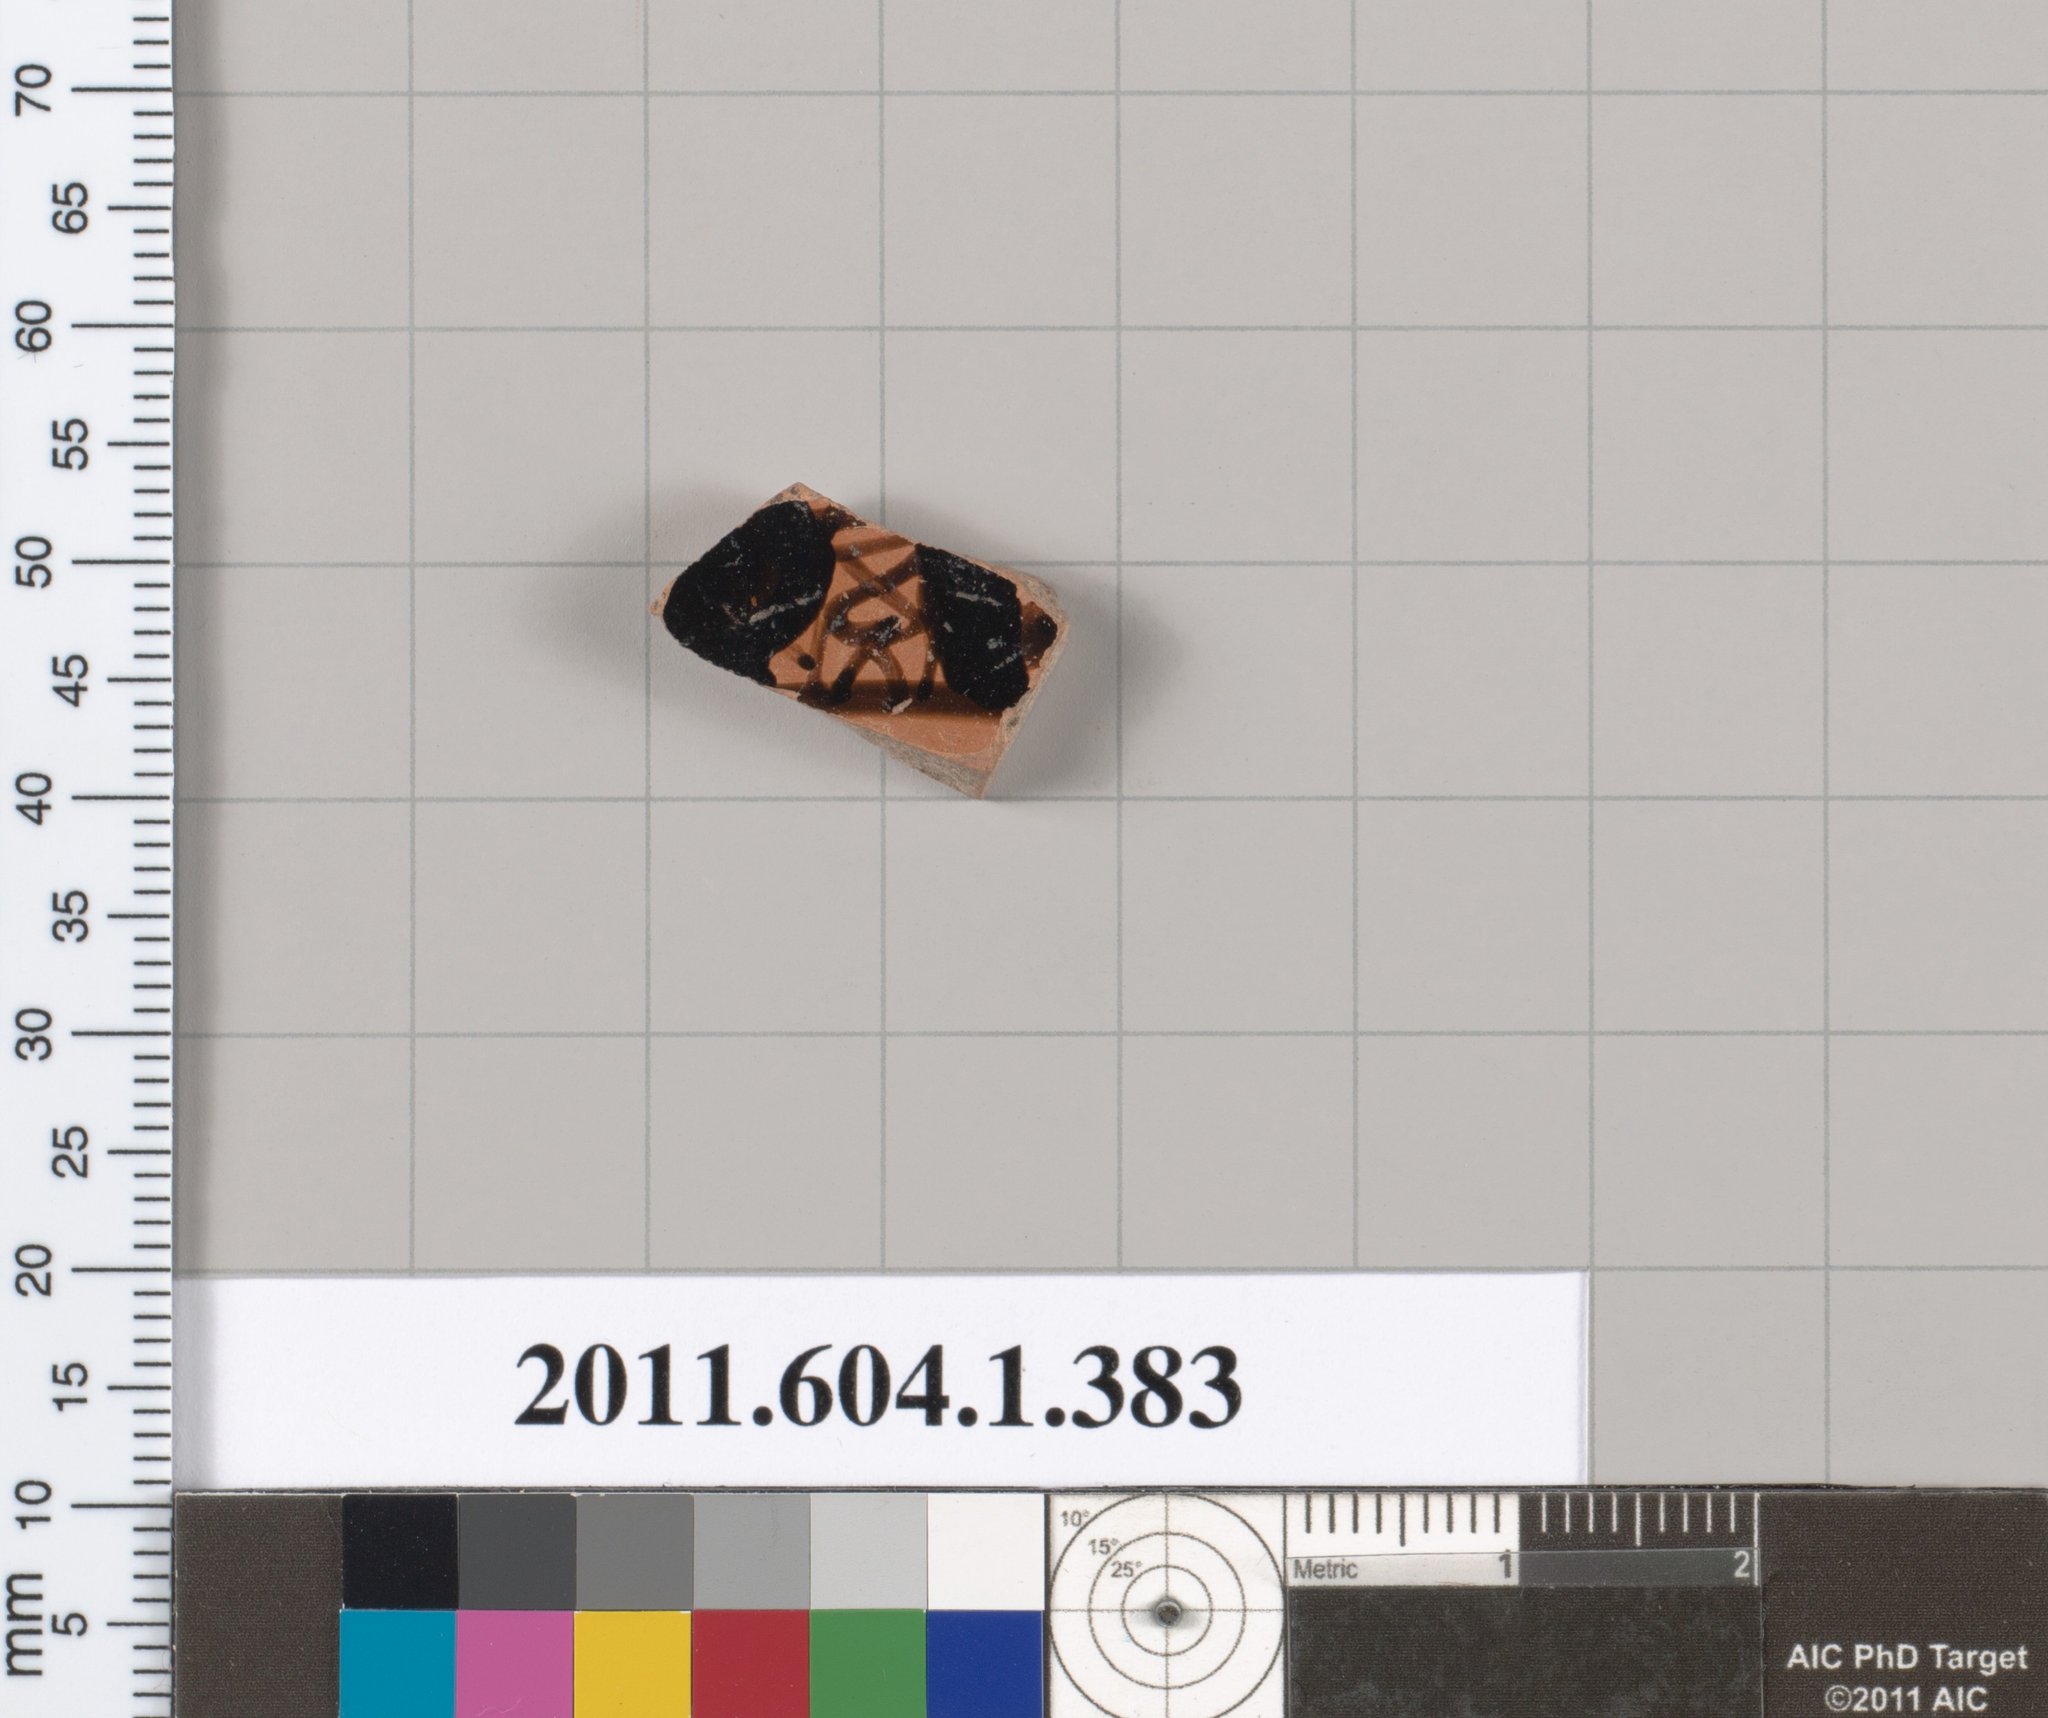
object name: kylix fragment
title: Terracotta fragment of a kylix (drinking cup)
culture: greek, attic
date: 475-451 BCE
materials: terracotta